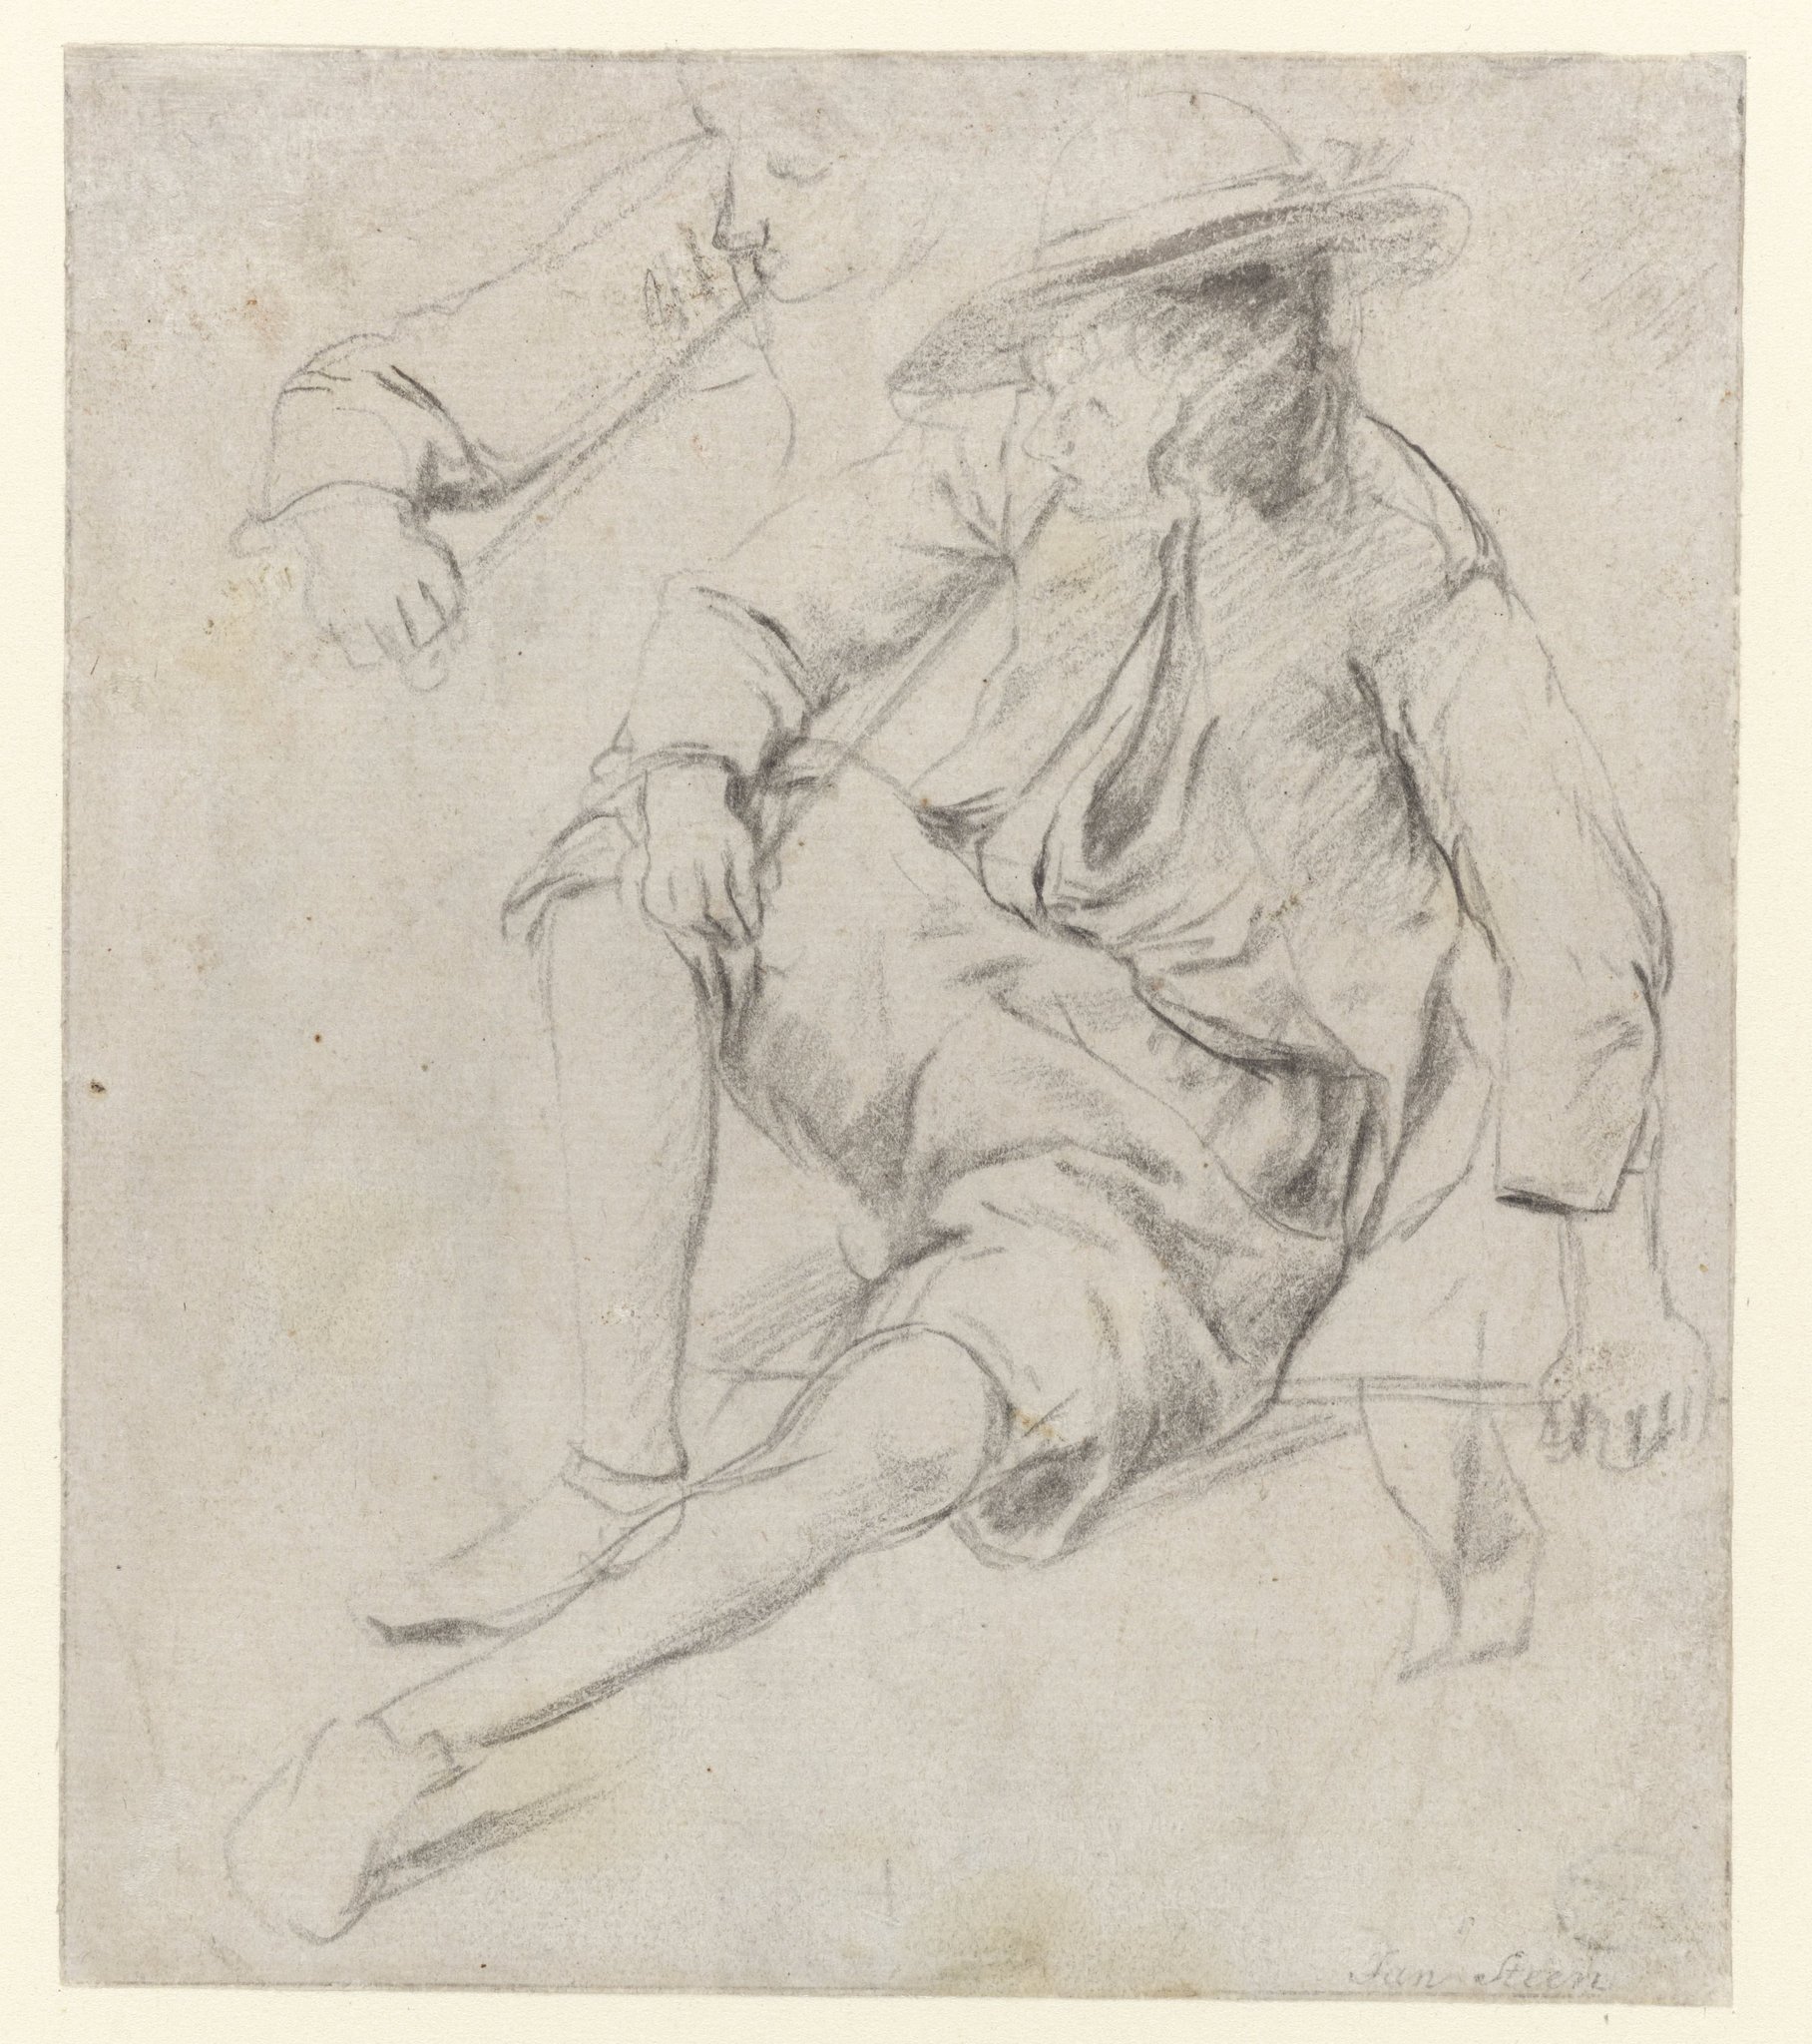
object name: drawing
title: Study of a Seated Man Smoking a Pipe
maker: jan havicksz. steen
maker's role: painter, print maker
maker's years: 1625-1679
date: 1650-1655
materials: chalk, ink, paper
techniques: brush, drawing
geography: the hague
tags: sitting figure, pipe ~ tobacco (+ taking (particular) foodstuffs: eating, drinking, smoking, chewing, etc.)